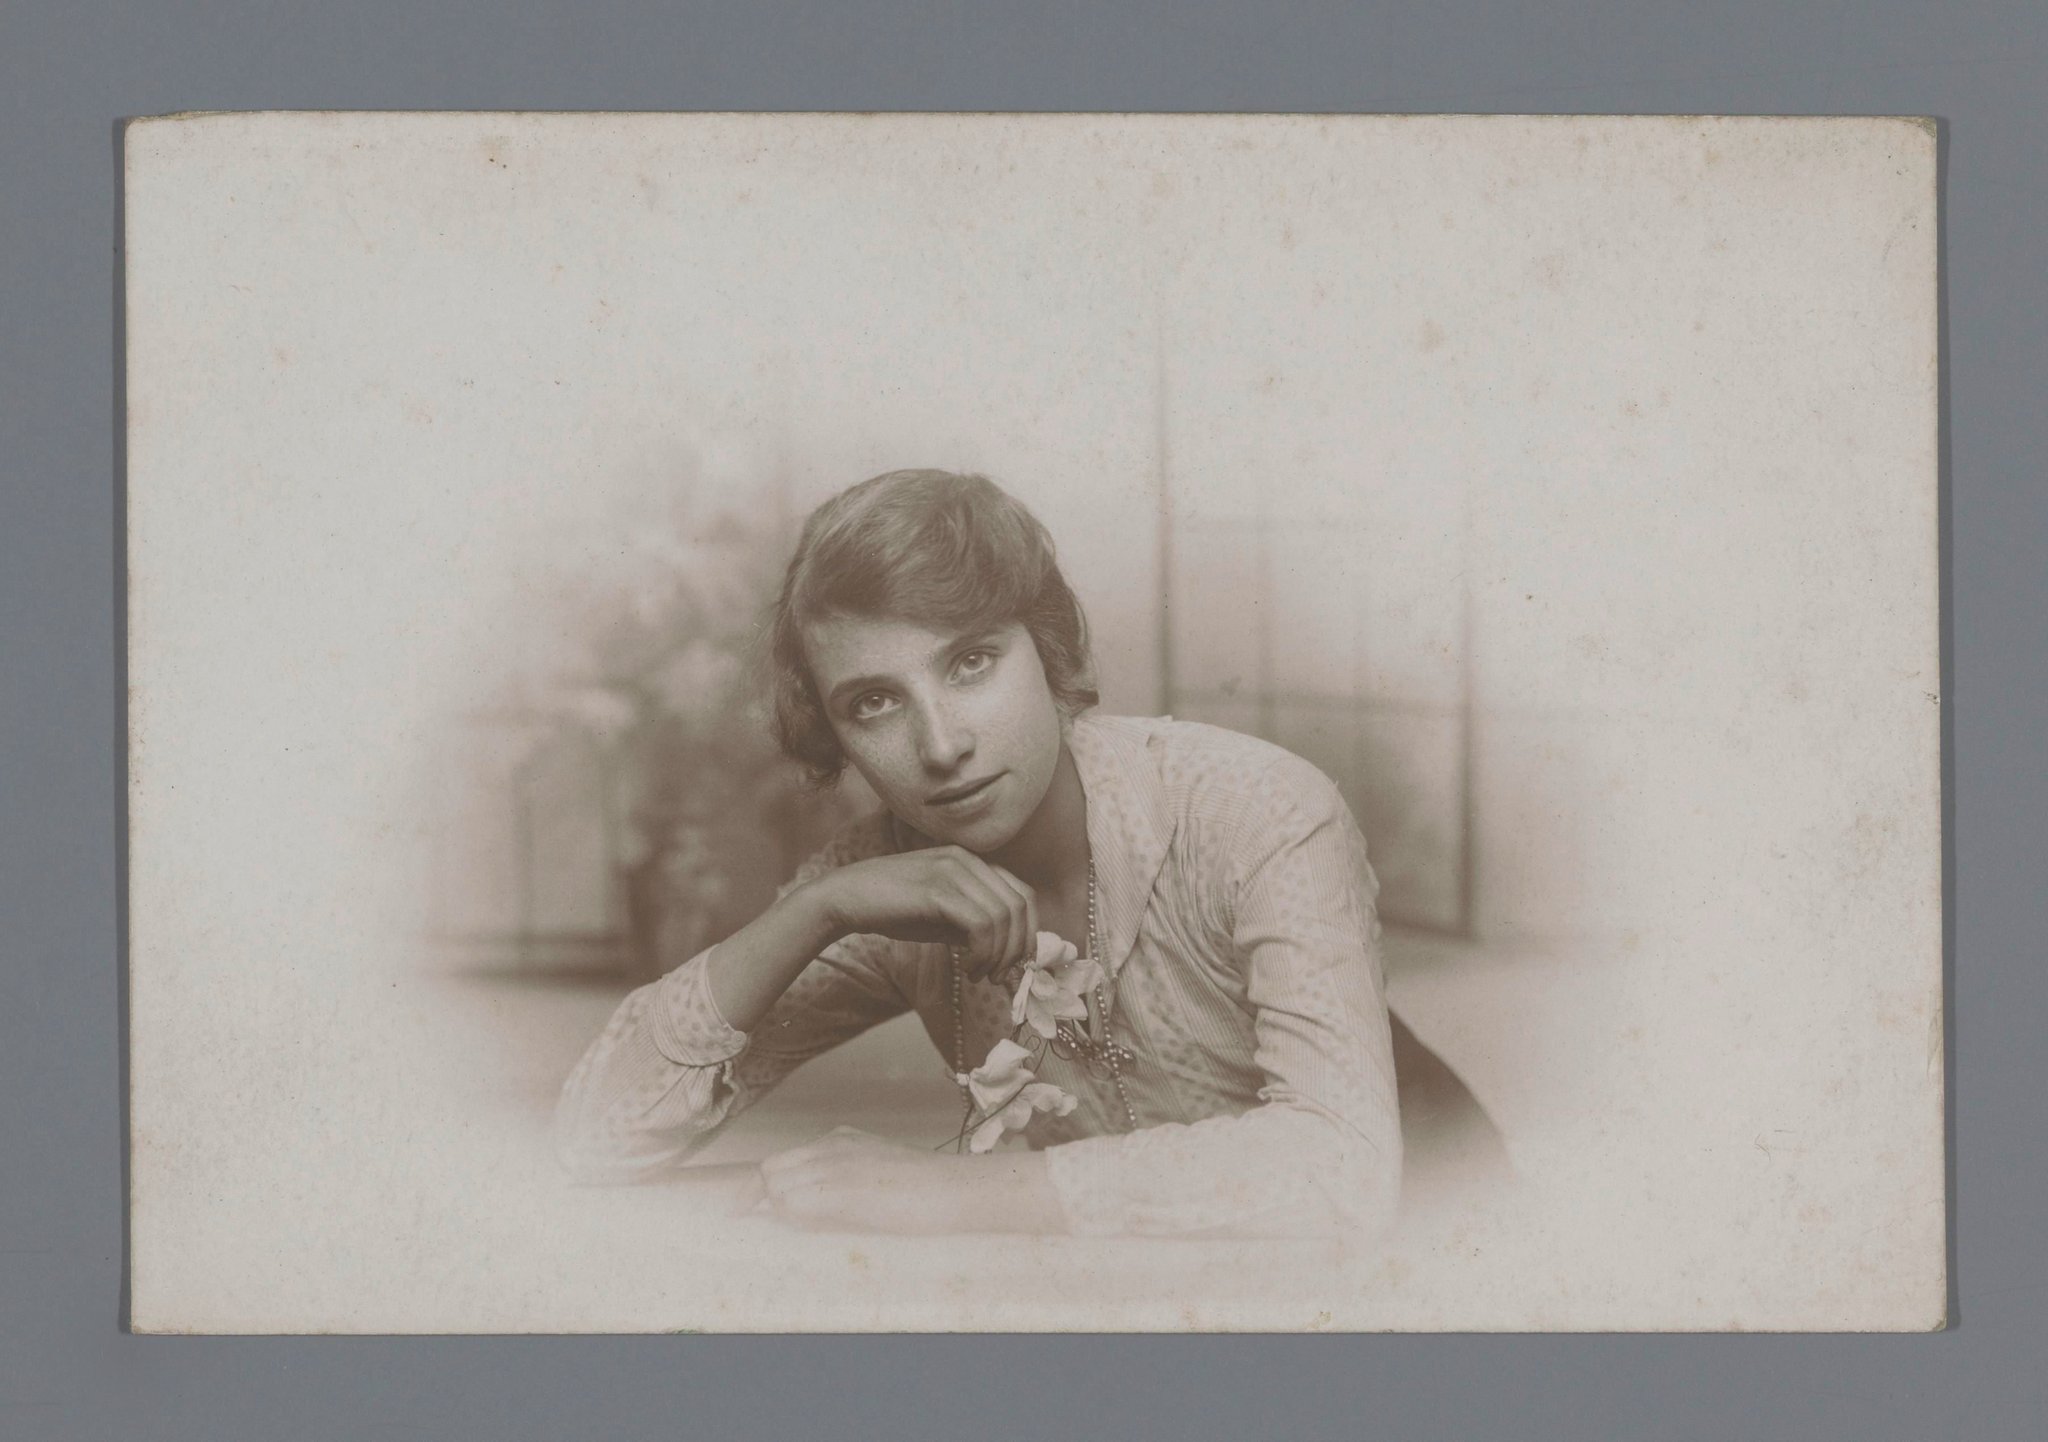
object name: ansichtkaart, prentbriefkaart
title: Portret van een onbekende jonge vrouw met lelies in de hand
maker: Anonymous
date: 1907-1920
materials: photographic support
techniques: gelatin silver print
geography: battersea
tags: adolescent, young woman, maiden, flowers: lily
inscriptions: inscription: ‘Battersea' Lily's daughter’